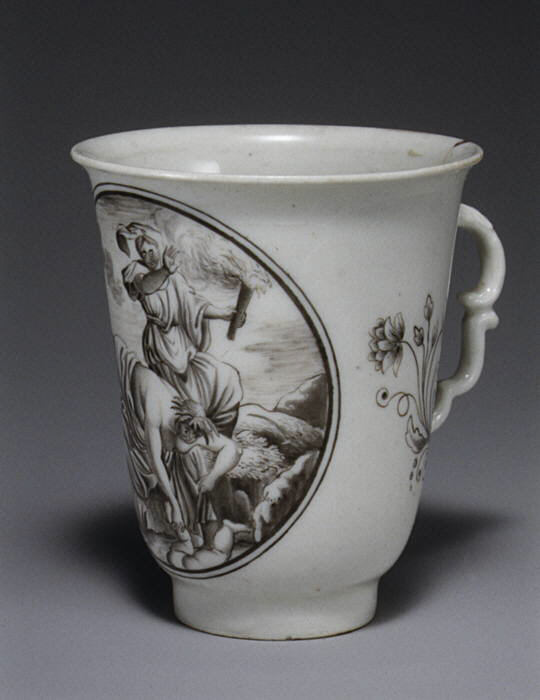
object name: cup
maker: meissen manufactory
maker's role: manufactory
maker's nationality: german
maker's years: 1710-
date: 1730-1740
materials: hard paste porcelain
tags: men,flowers